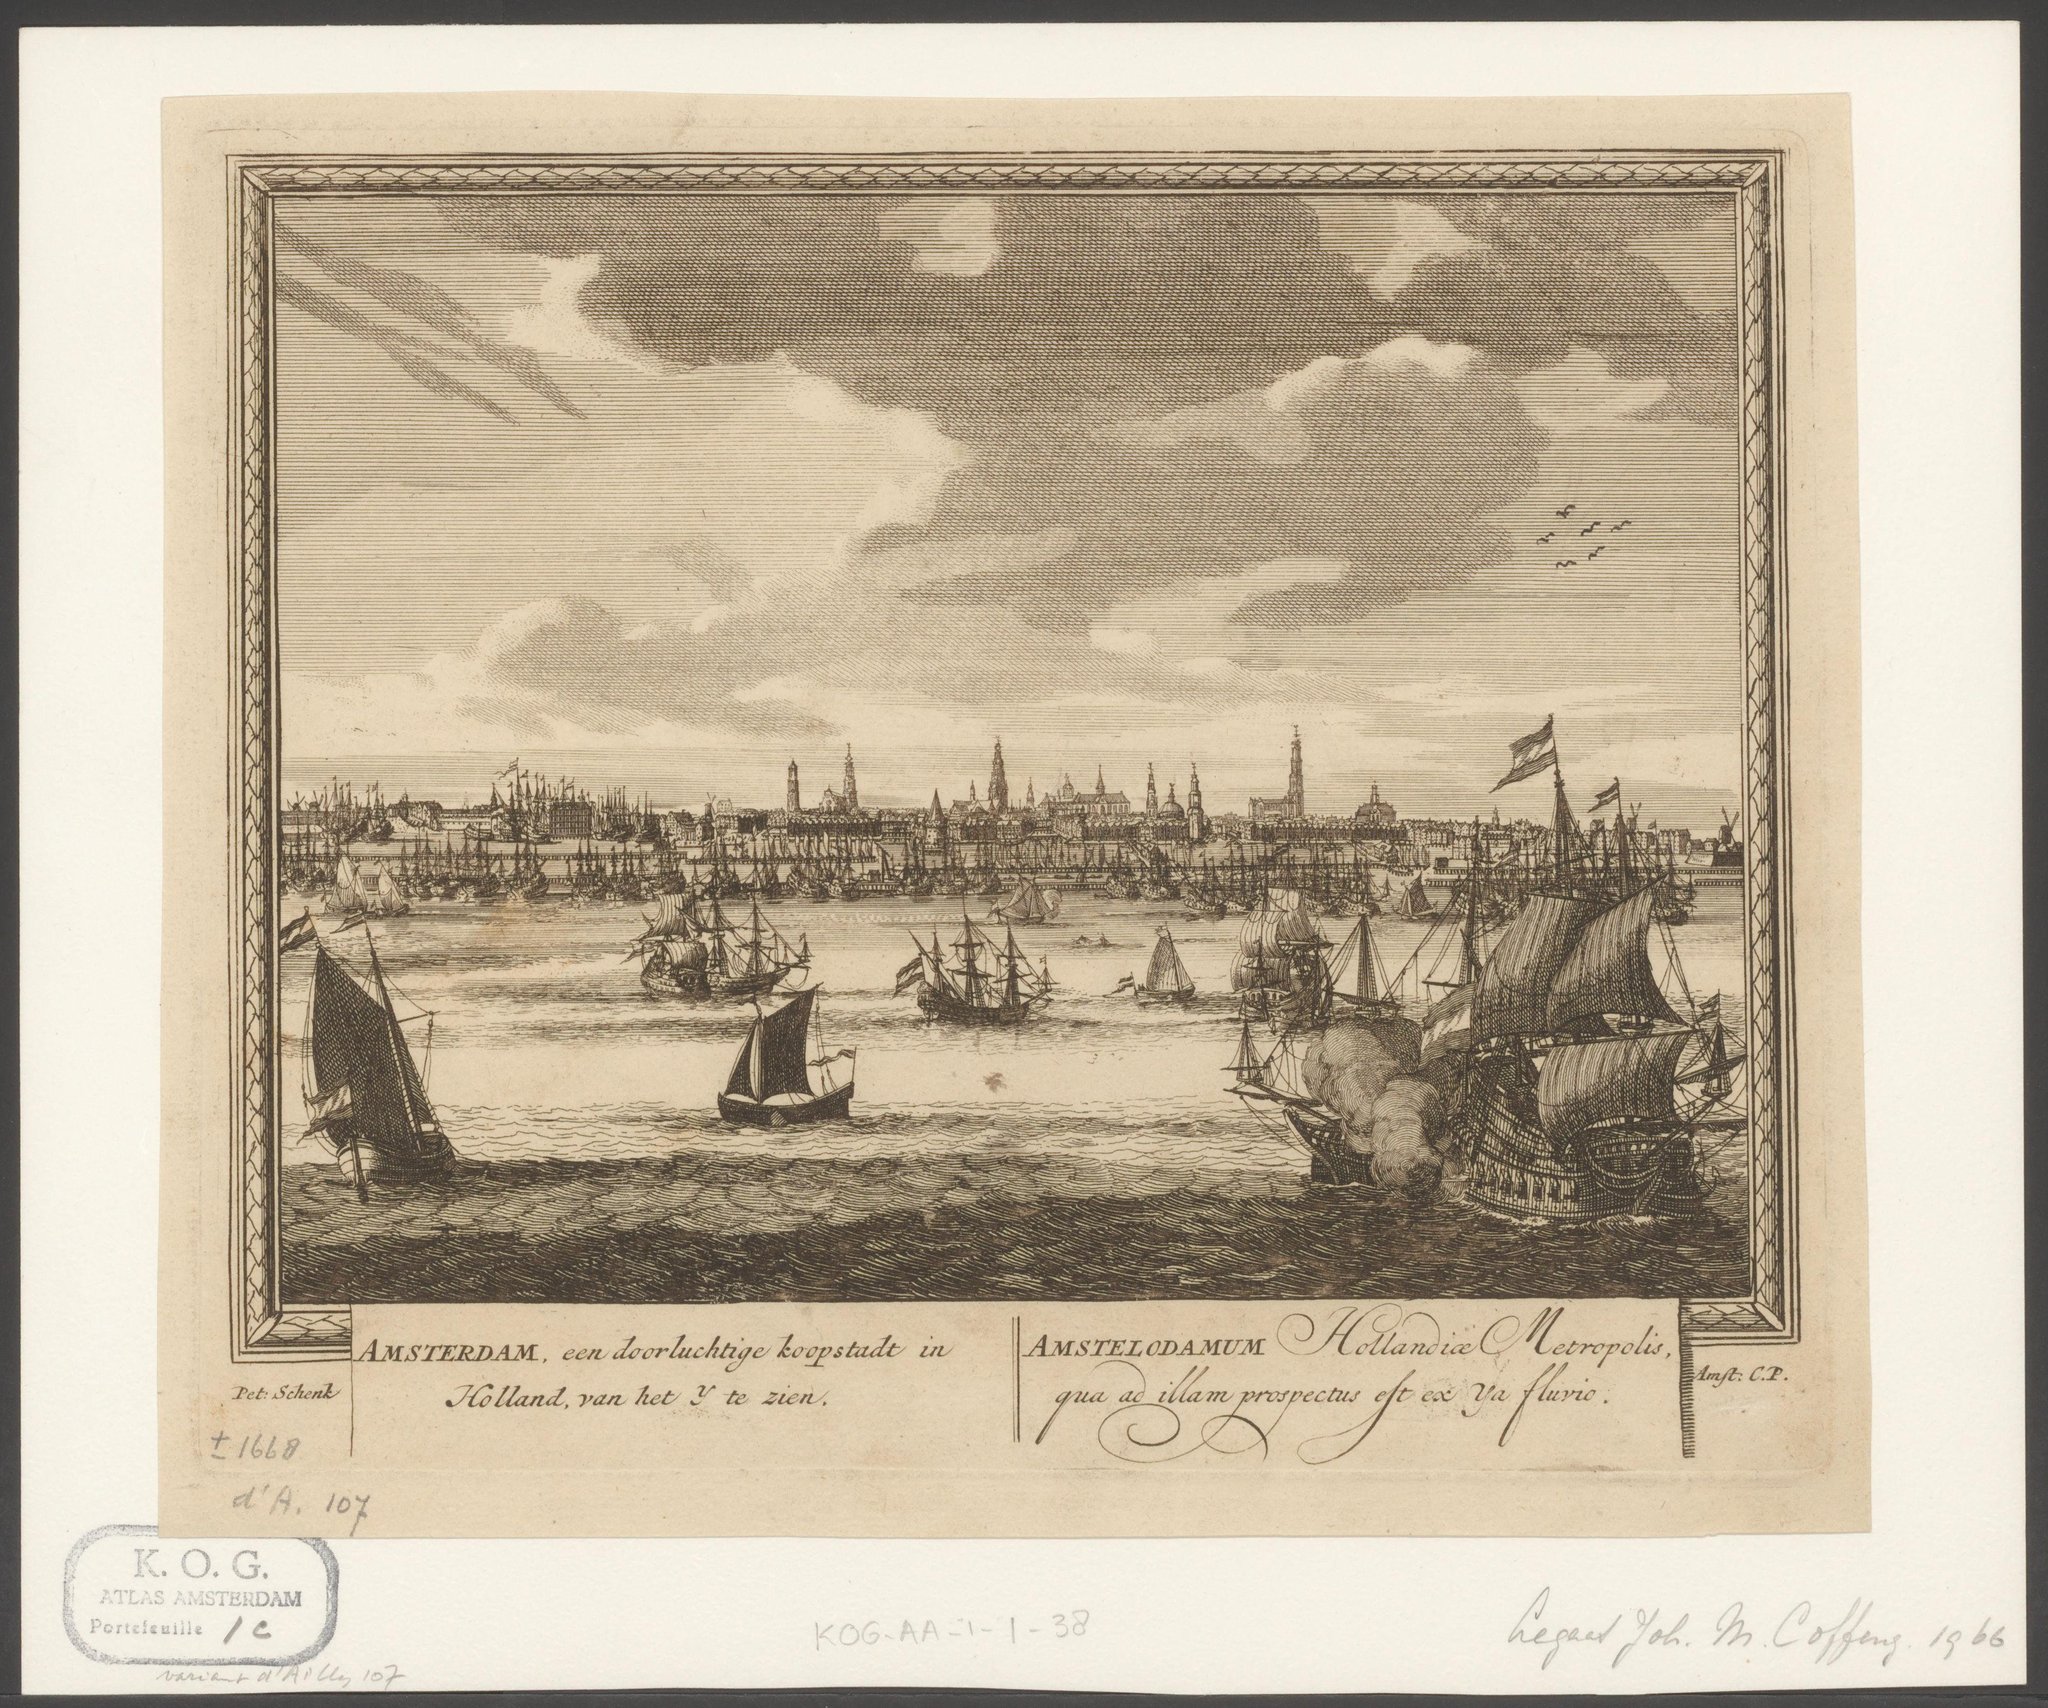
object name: print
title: Gezicht op de stad Amsterdam vanaf het IJ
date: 1695-1711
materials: paper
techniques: etching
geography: amsterdam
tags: city-view in general; 'veduta', river, ships (in general) - cc - more than one ship, amsterdam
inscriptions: collector's mark: ‘1c’ Lugt 1641b, inscription: ‘Legaat Joh. M. Coffeng.1966’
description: Onderwerpsrubriek binnen de Atlas Amsterdam: Gezichten van den geheelen IJkant der Stad.